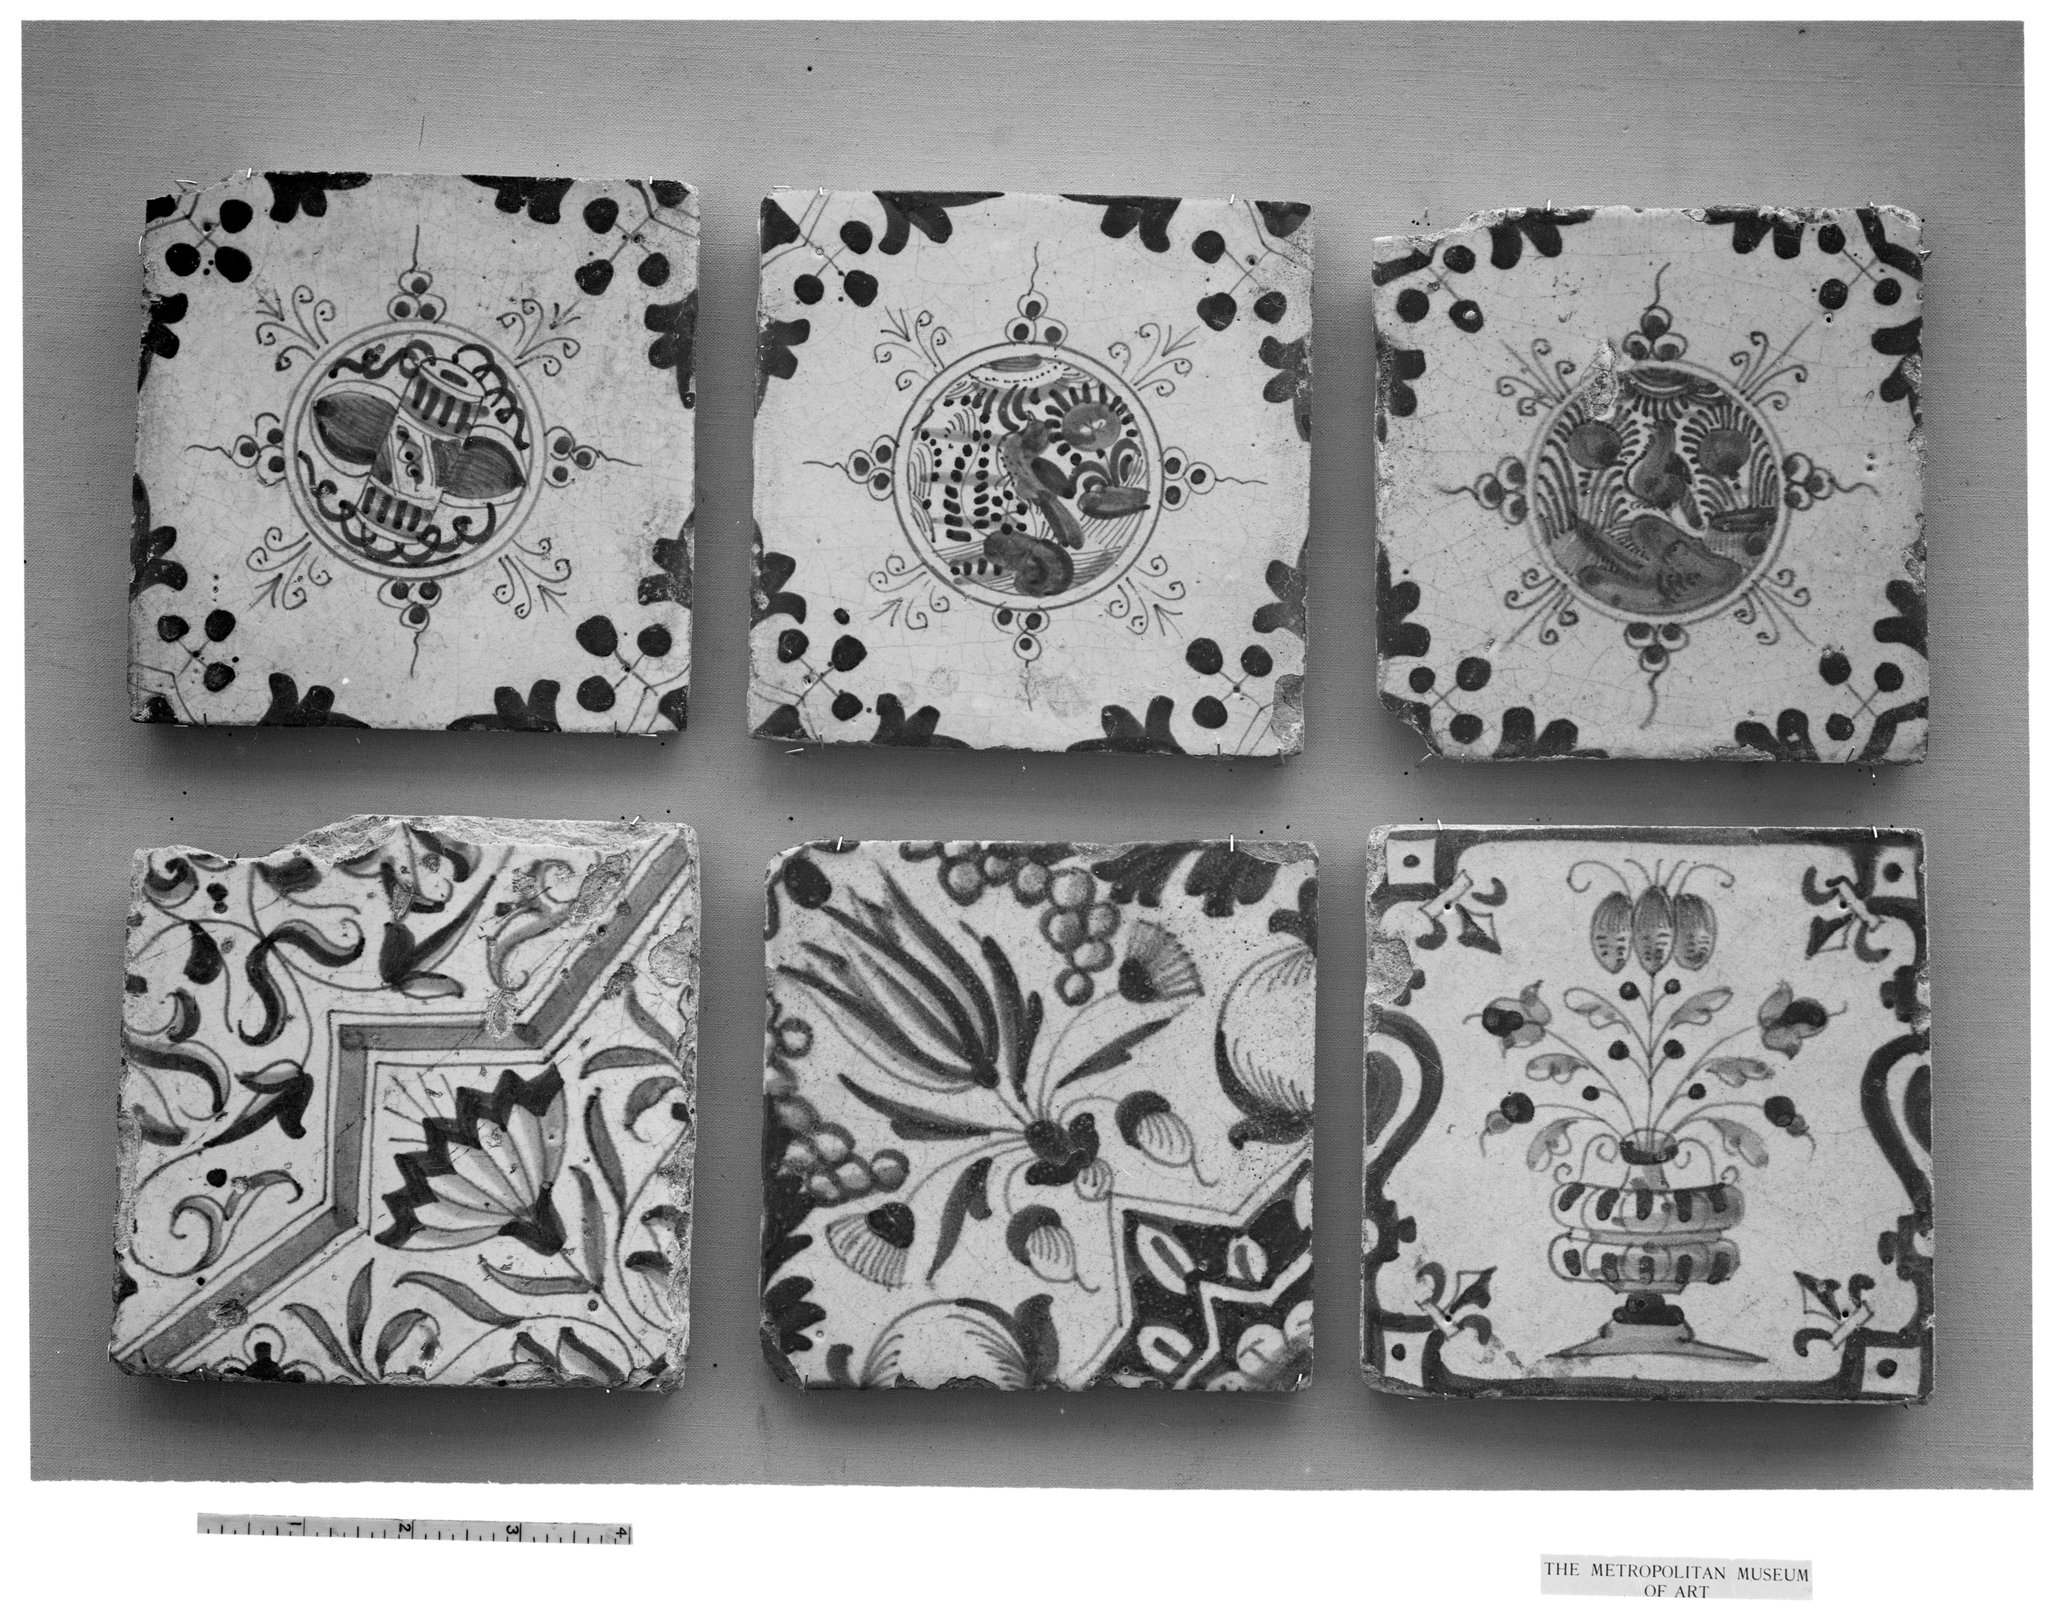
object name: tile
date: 1701-1900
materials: earthenware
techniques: glazing